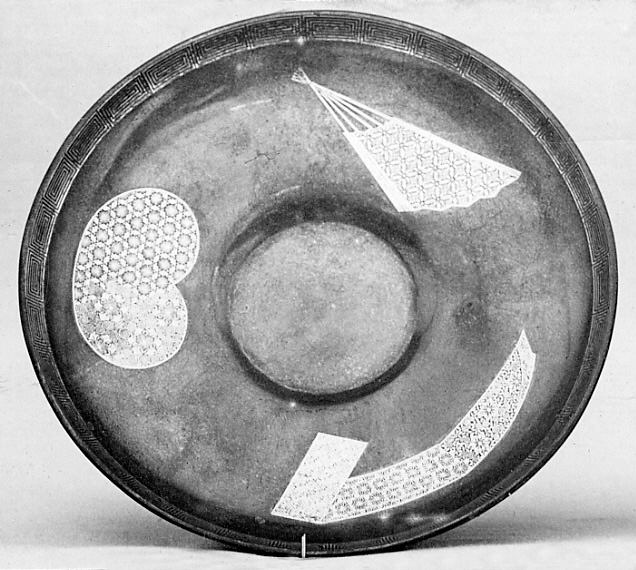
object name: saucer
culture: japanese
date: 1801-1900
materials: bronze, gold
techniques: inlay